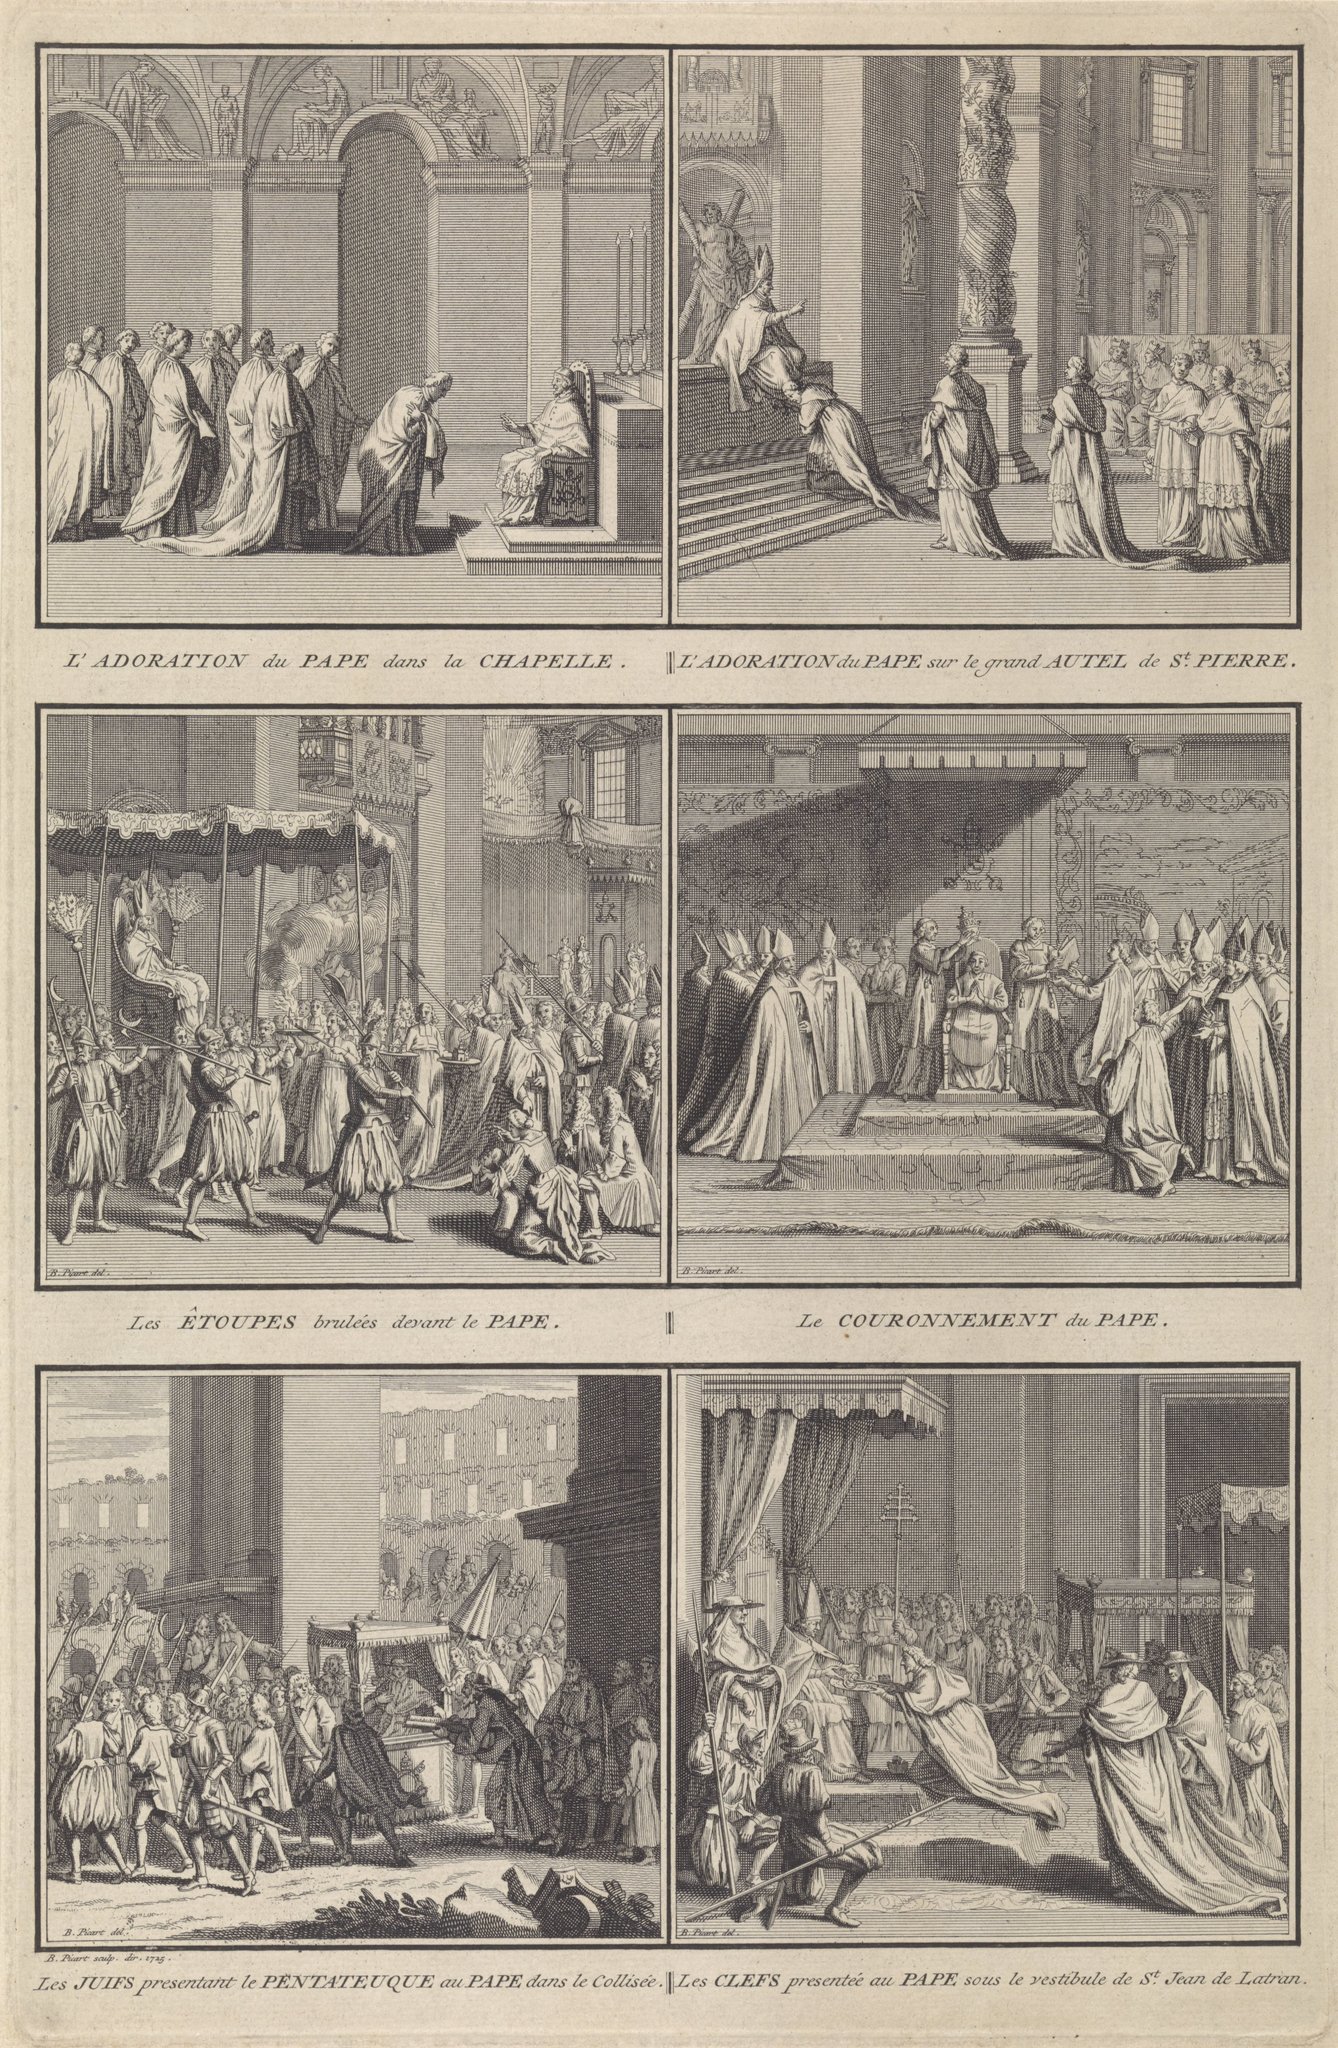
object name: print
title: Installatie en kroning van een nieuwe paus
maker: bernard picart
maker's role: draughtsman, print maker, publisher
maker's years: 1673-1733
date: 1725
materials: paper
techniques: engraving, etching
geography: amsterdam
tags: installation of a pope, papal coronation, kissing the pope's feet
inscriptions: collector's mark: Lugt 2228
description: Blad met zes voorstellingen van de gebeurtenissen, die volgen op de verkiezing van een nieuwe paus. Linksboven: De kardinalen aanbidden de nieuwe paus. Rechtsboven: Aanbidding van de nieuwe paus in de Sint Pieter. Links midden: Ronddragen van de nieuwe paus. Rechts midden: De kroning van de paus. Linksonder: Joden bieden de paus de Thora aan in het Colloseum. Rechtsonder: Het aanbieden van de sleutels van Petrus aan de paus in Sint-Jan van Lateranen.